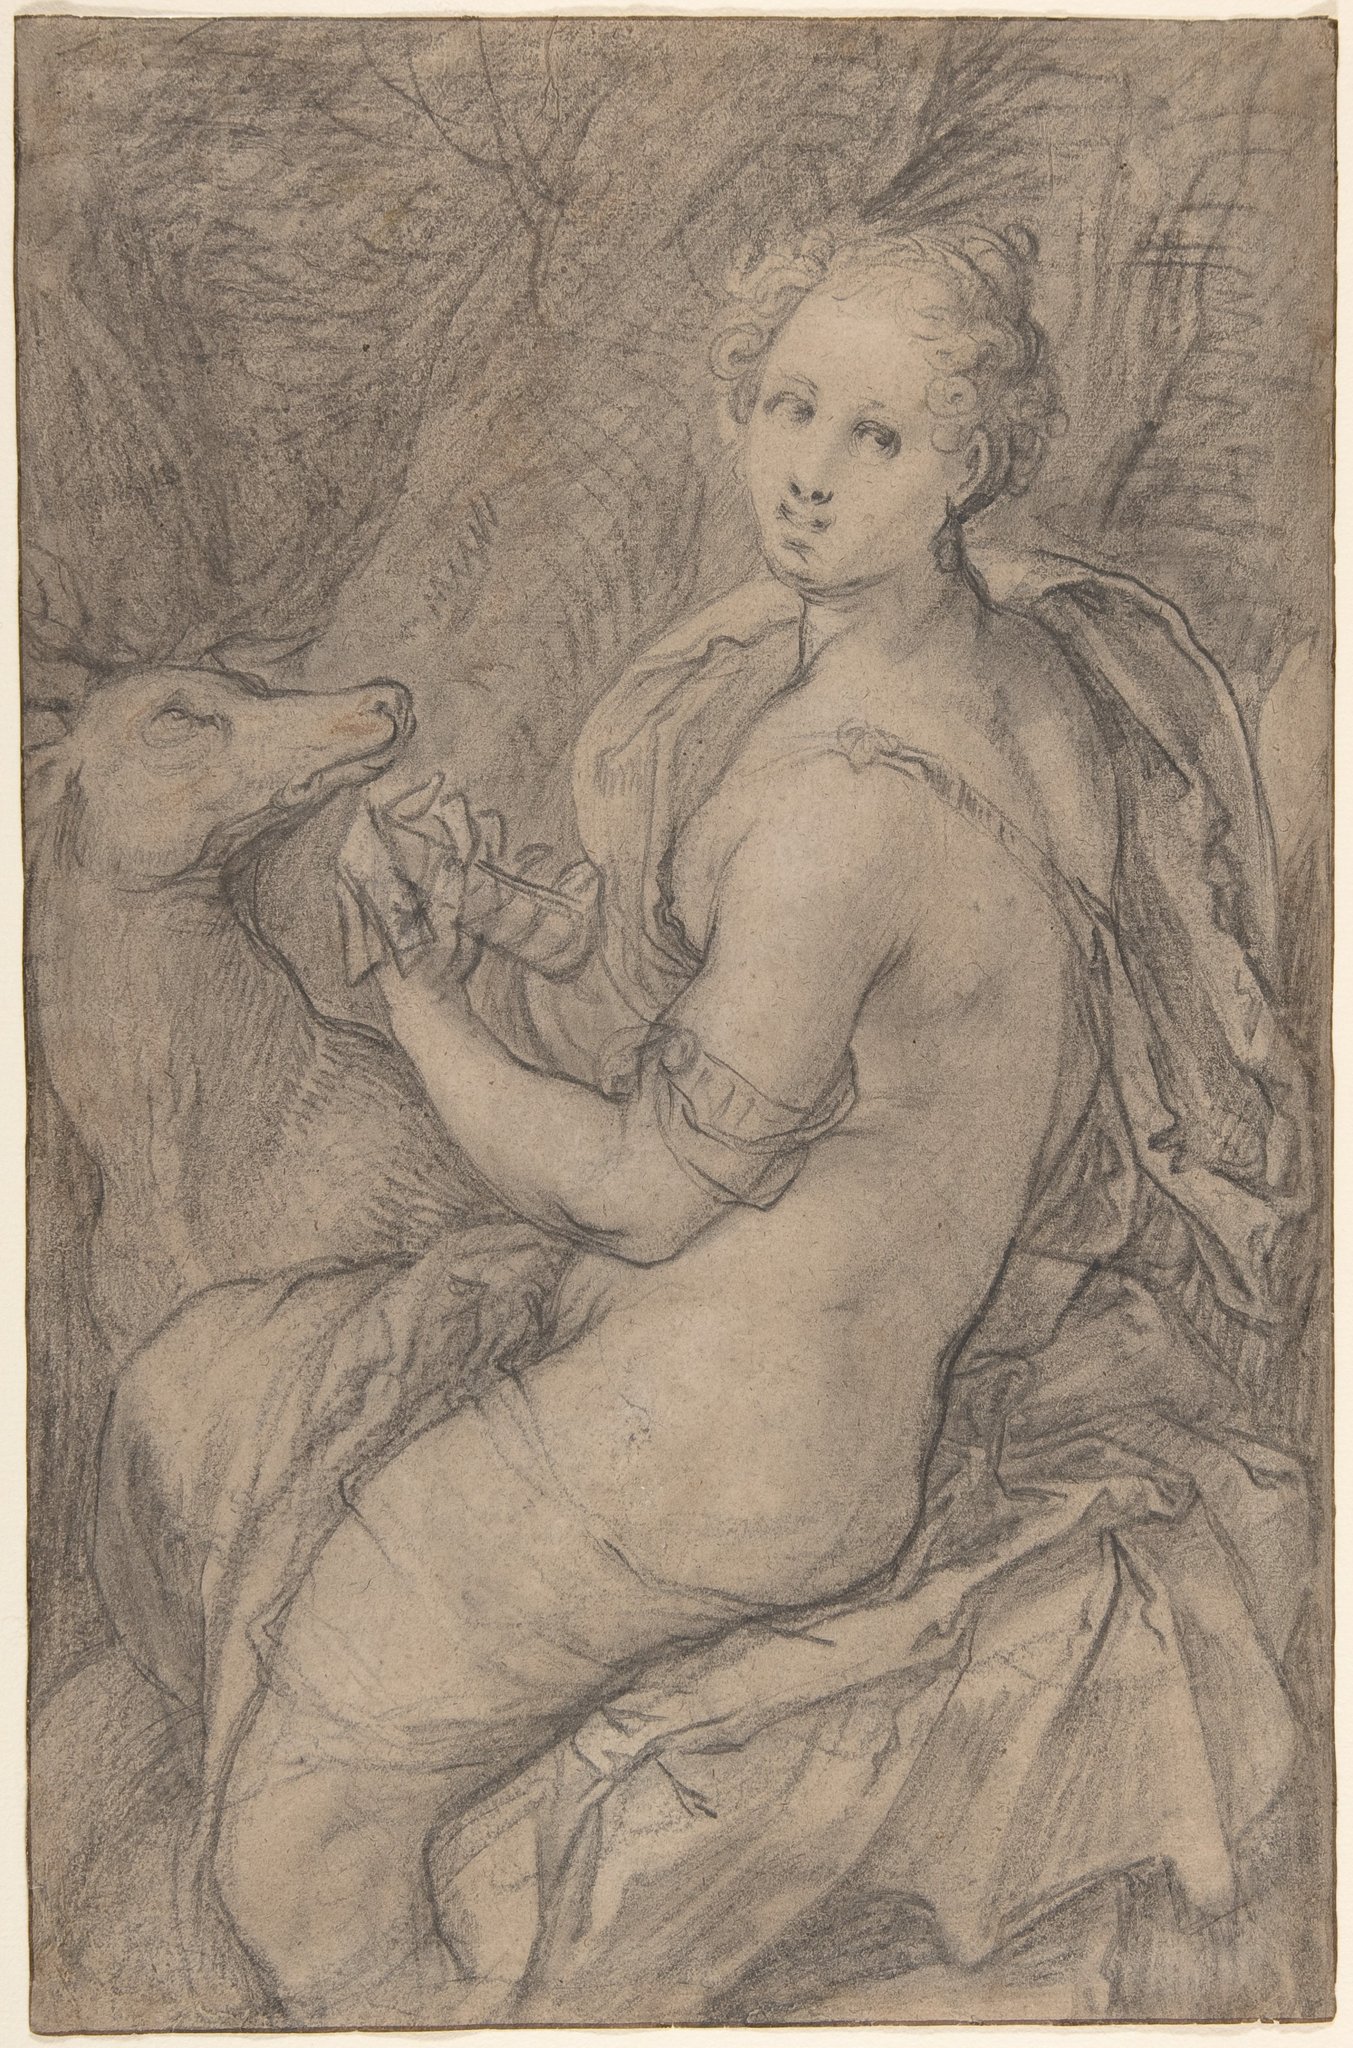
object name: drawing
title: The Sense of Hearing; verso: light sketch of a woman's head and an arm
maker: hendrick goltzius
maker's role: artist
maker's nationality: netherlandish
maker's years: 1558-1617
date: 1567-1633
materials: chalk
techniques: heightening, stumping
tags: women,deer